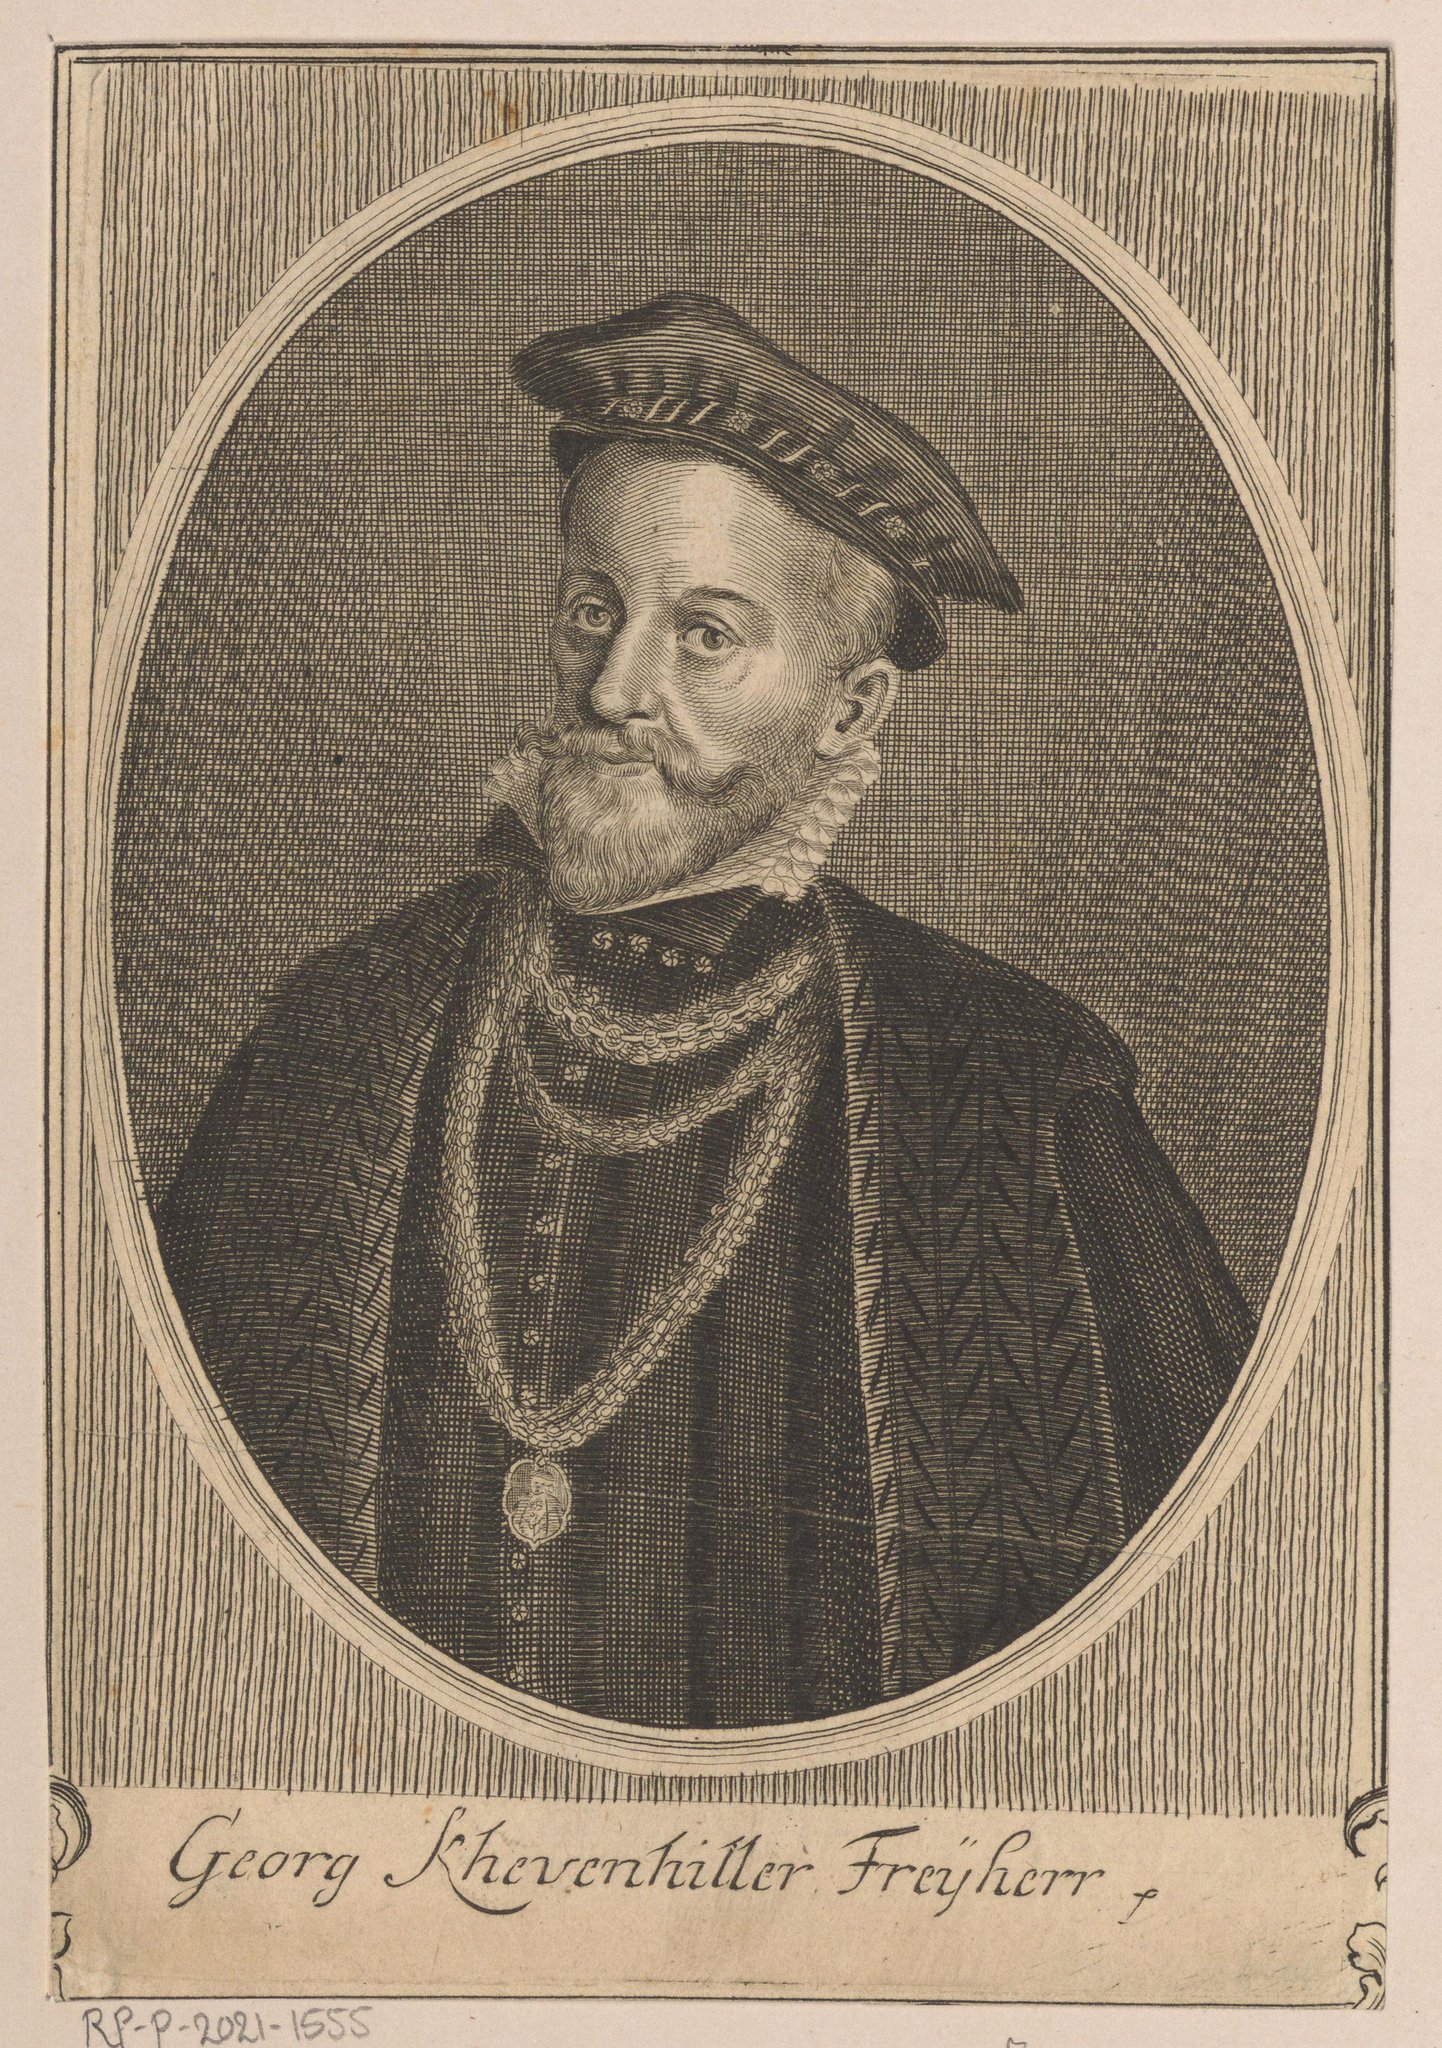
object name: print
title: Portret van Georg von Khevenhüller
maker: Anonymous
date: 1722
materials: paper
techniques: engraving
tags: historical persons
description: Prent met andere omlijsting gebruikt in: Conterfet-Kupferstich soviel man deren zu handen bringen können (...). Leipzig: Moritz Georg Weidmann, 1722, dl. 2.